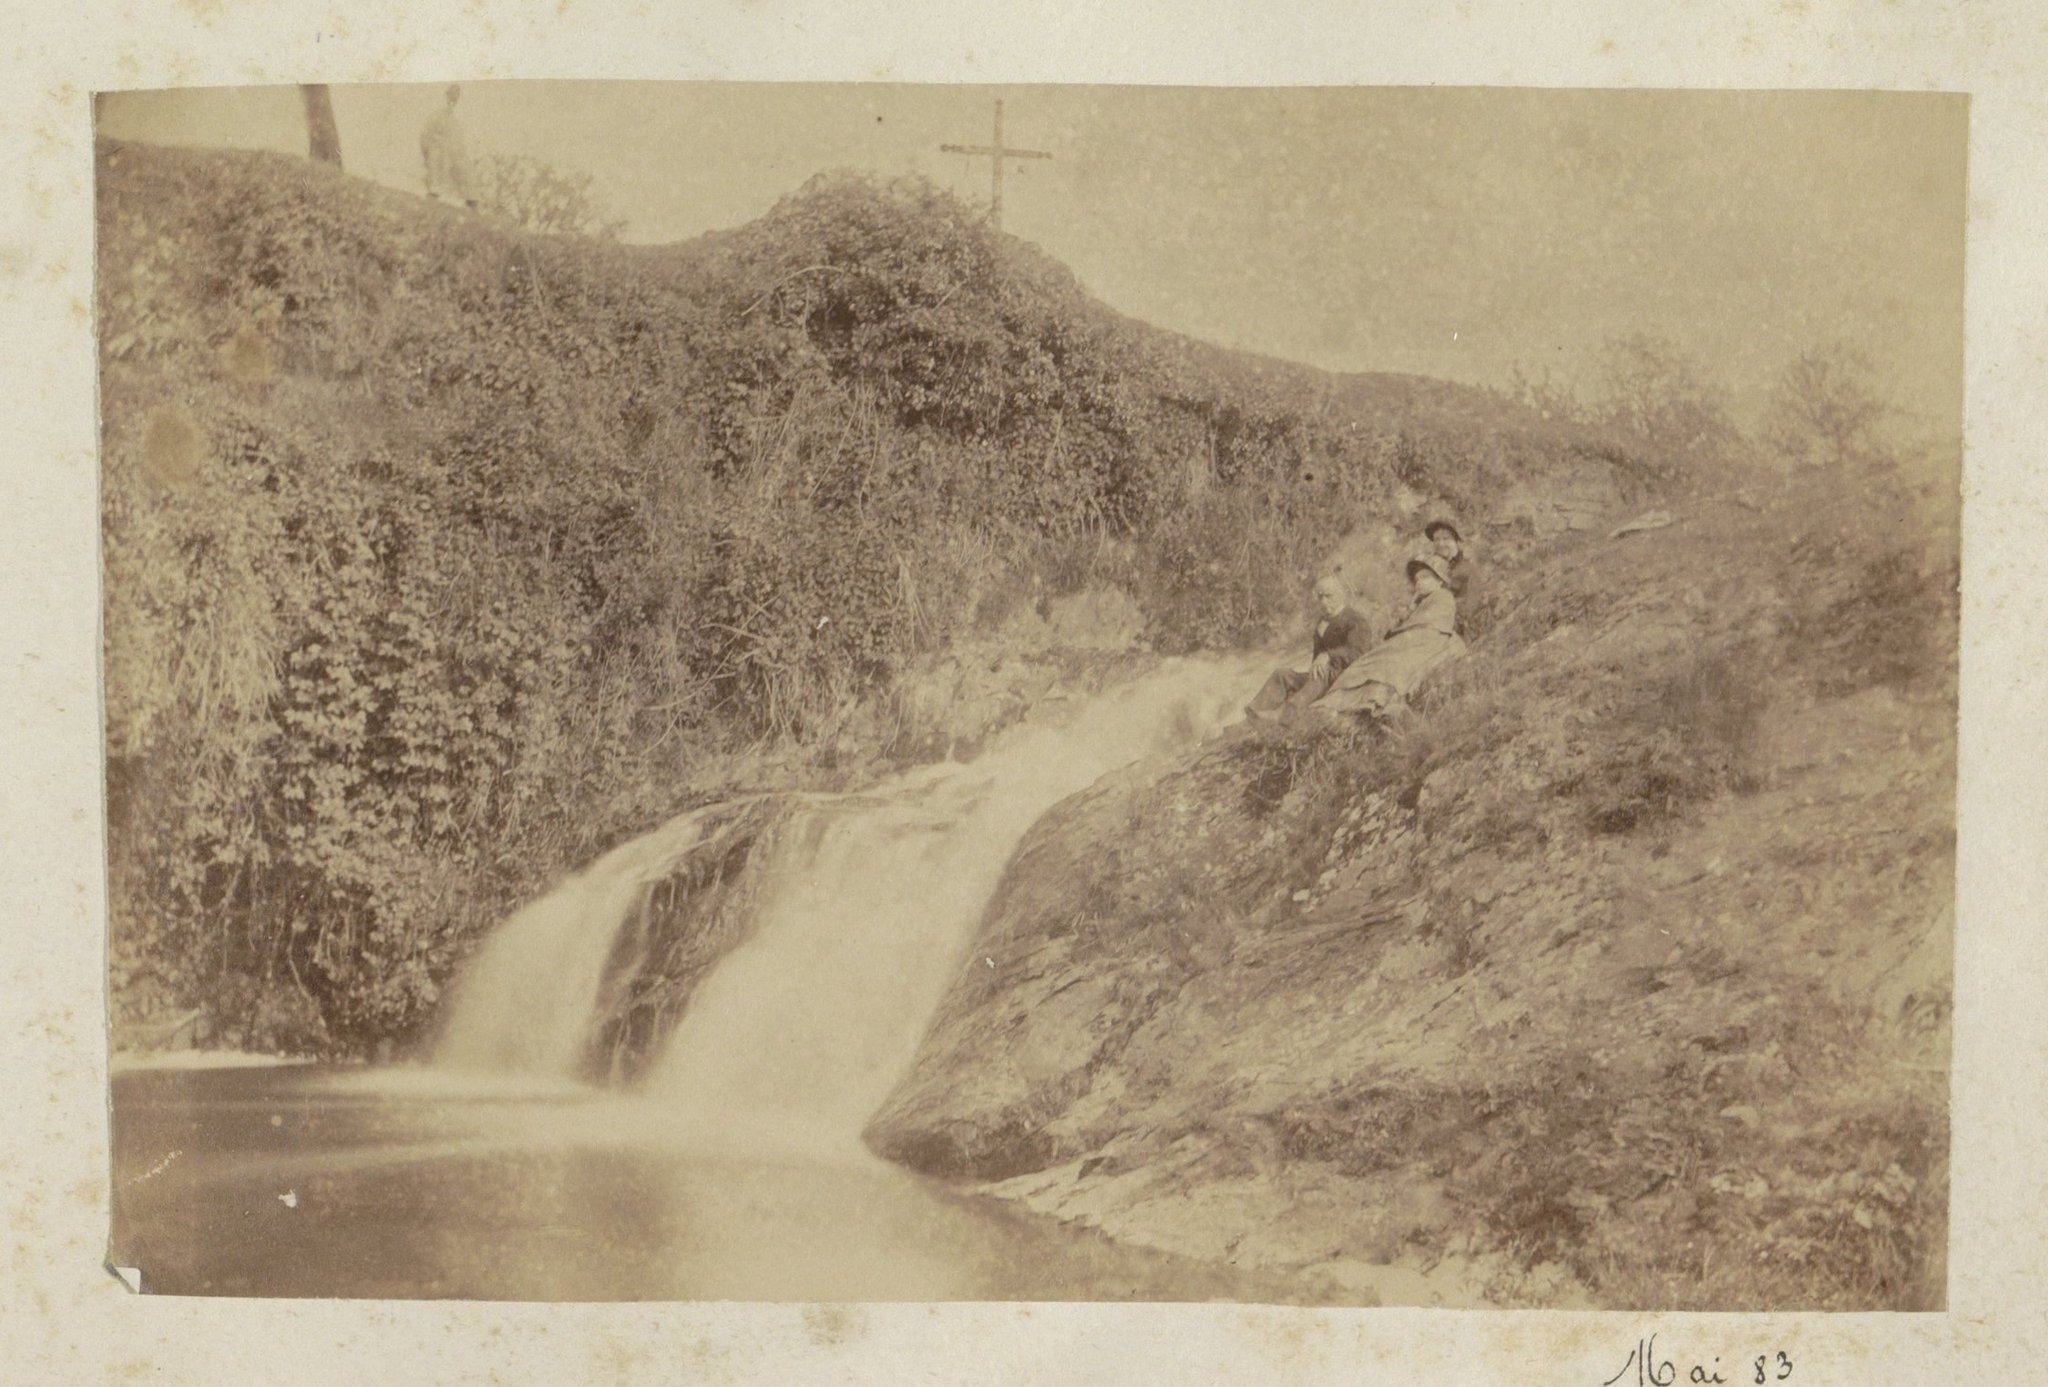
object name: photograph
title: Gezelschap liggend naast een waterval in Frankrijk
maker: Anonymous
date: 1805-1883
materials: photographic support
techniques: albumen print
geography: france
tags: waterfall, france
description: Onderdeel van Album van een Franse amateurfotograaf met opnames van familie, militairen, industrie, landschappen en bezienswaardigheden in Frankrijk.